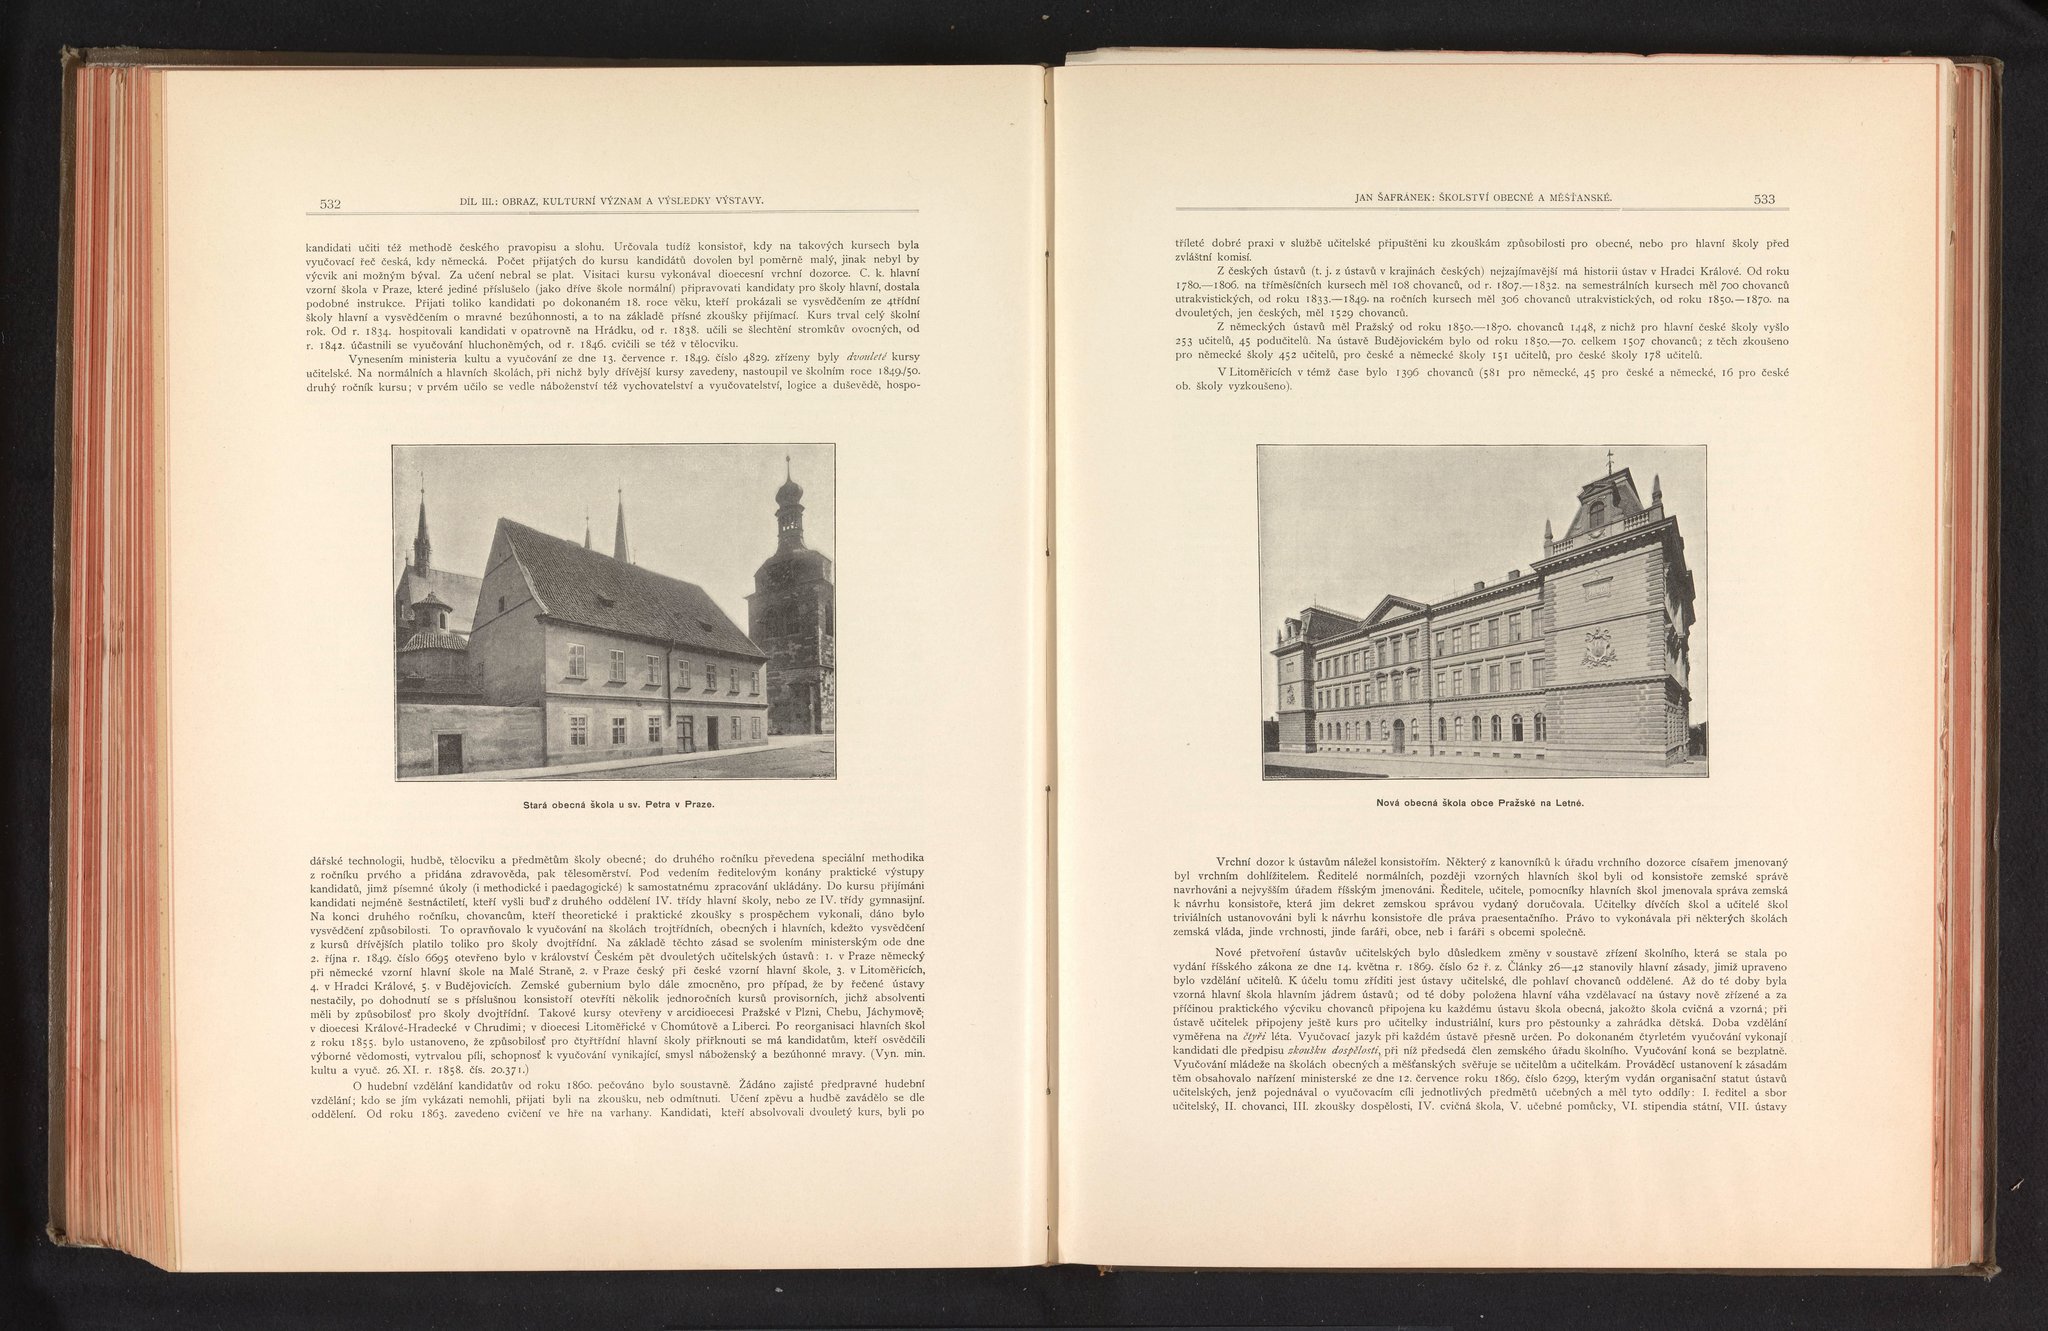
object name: page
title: Exterieur van een schoolgebouw te Praag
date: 1891-1895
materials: paper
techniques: autotype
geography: prague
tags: façade (of house or building), elementary school; class, form